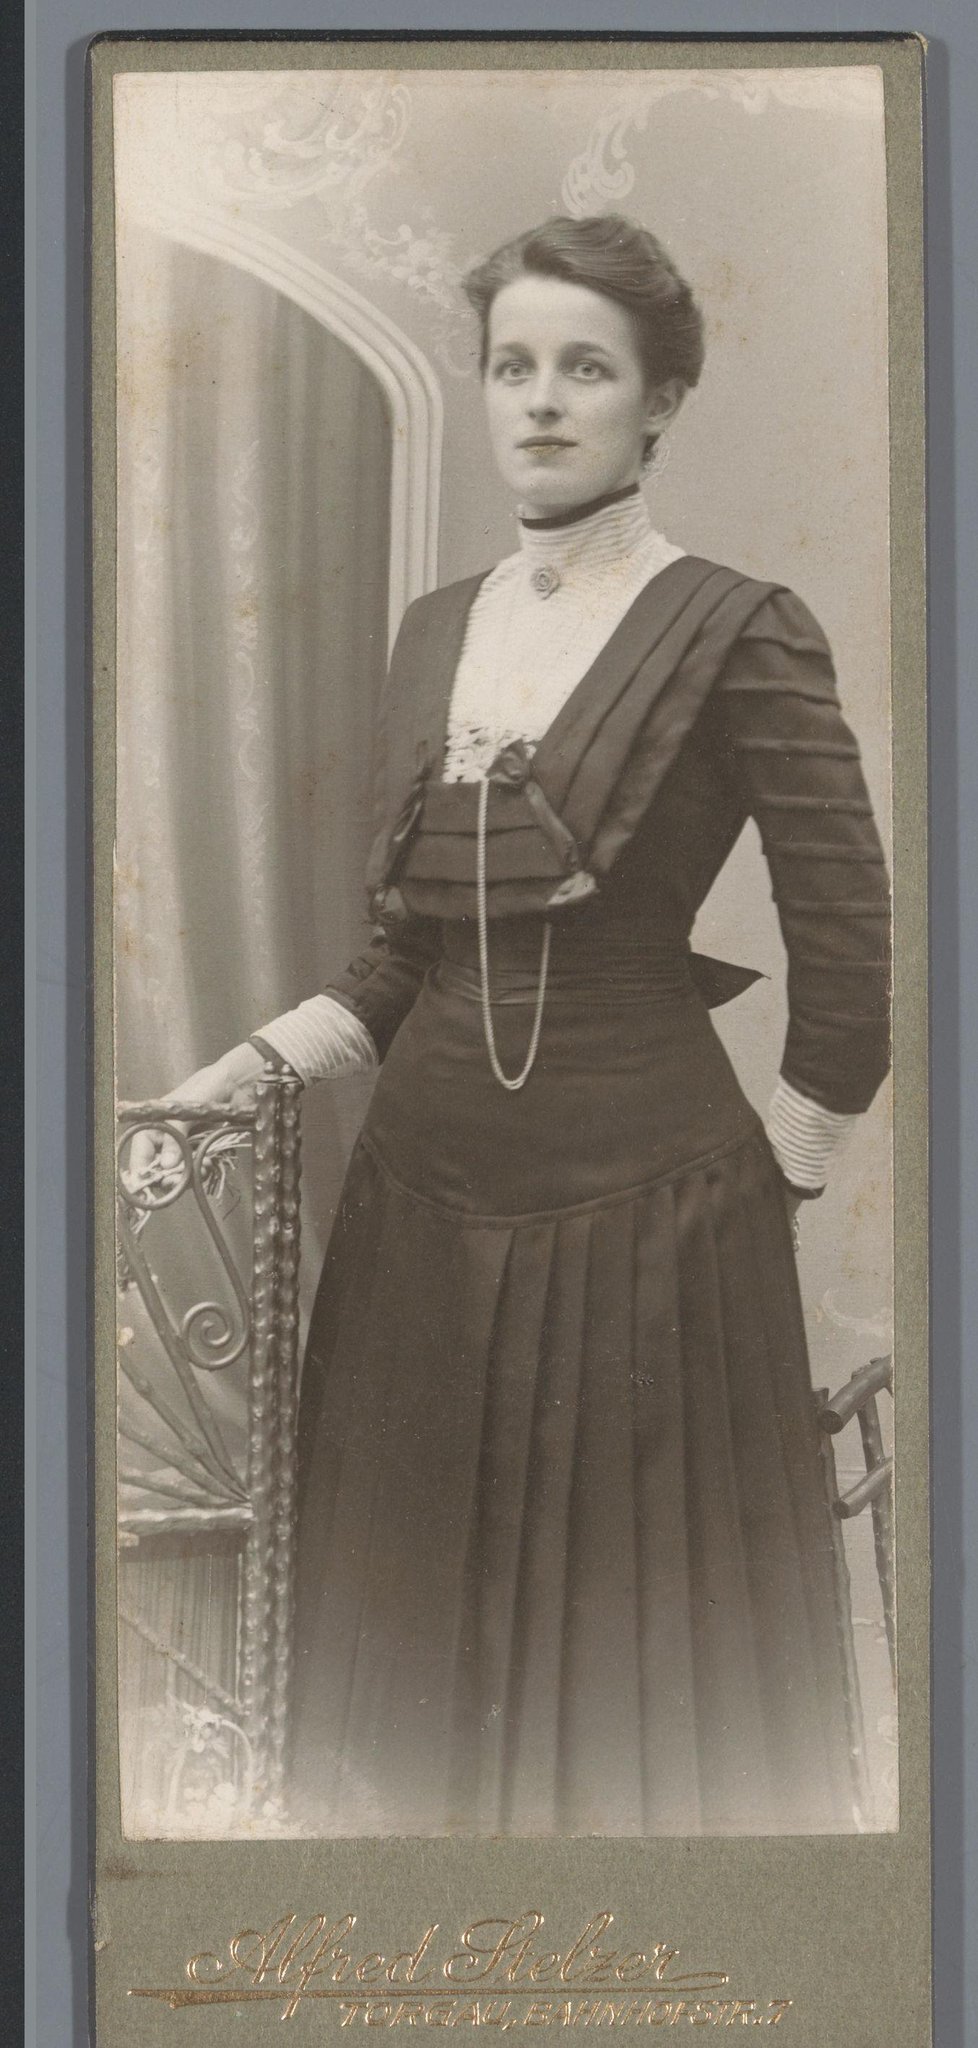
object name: carte de visite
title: Portret van een onbekende vrouw, aangeduid als Kathe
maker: alfred stelzer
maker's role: fotograaf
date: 1910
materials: paper, cardboard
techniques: gelatin silver print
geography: torgau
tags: adult woman, anonymous historical person portrayed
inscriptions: inscription: ‘[...]/ Kathe/ v. 3, Oktober 1910.’, address: ‘TORGAU, BAHNHOFSTR. 7’